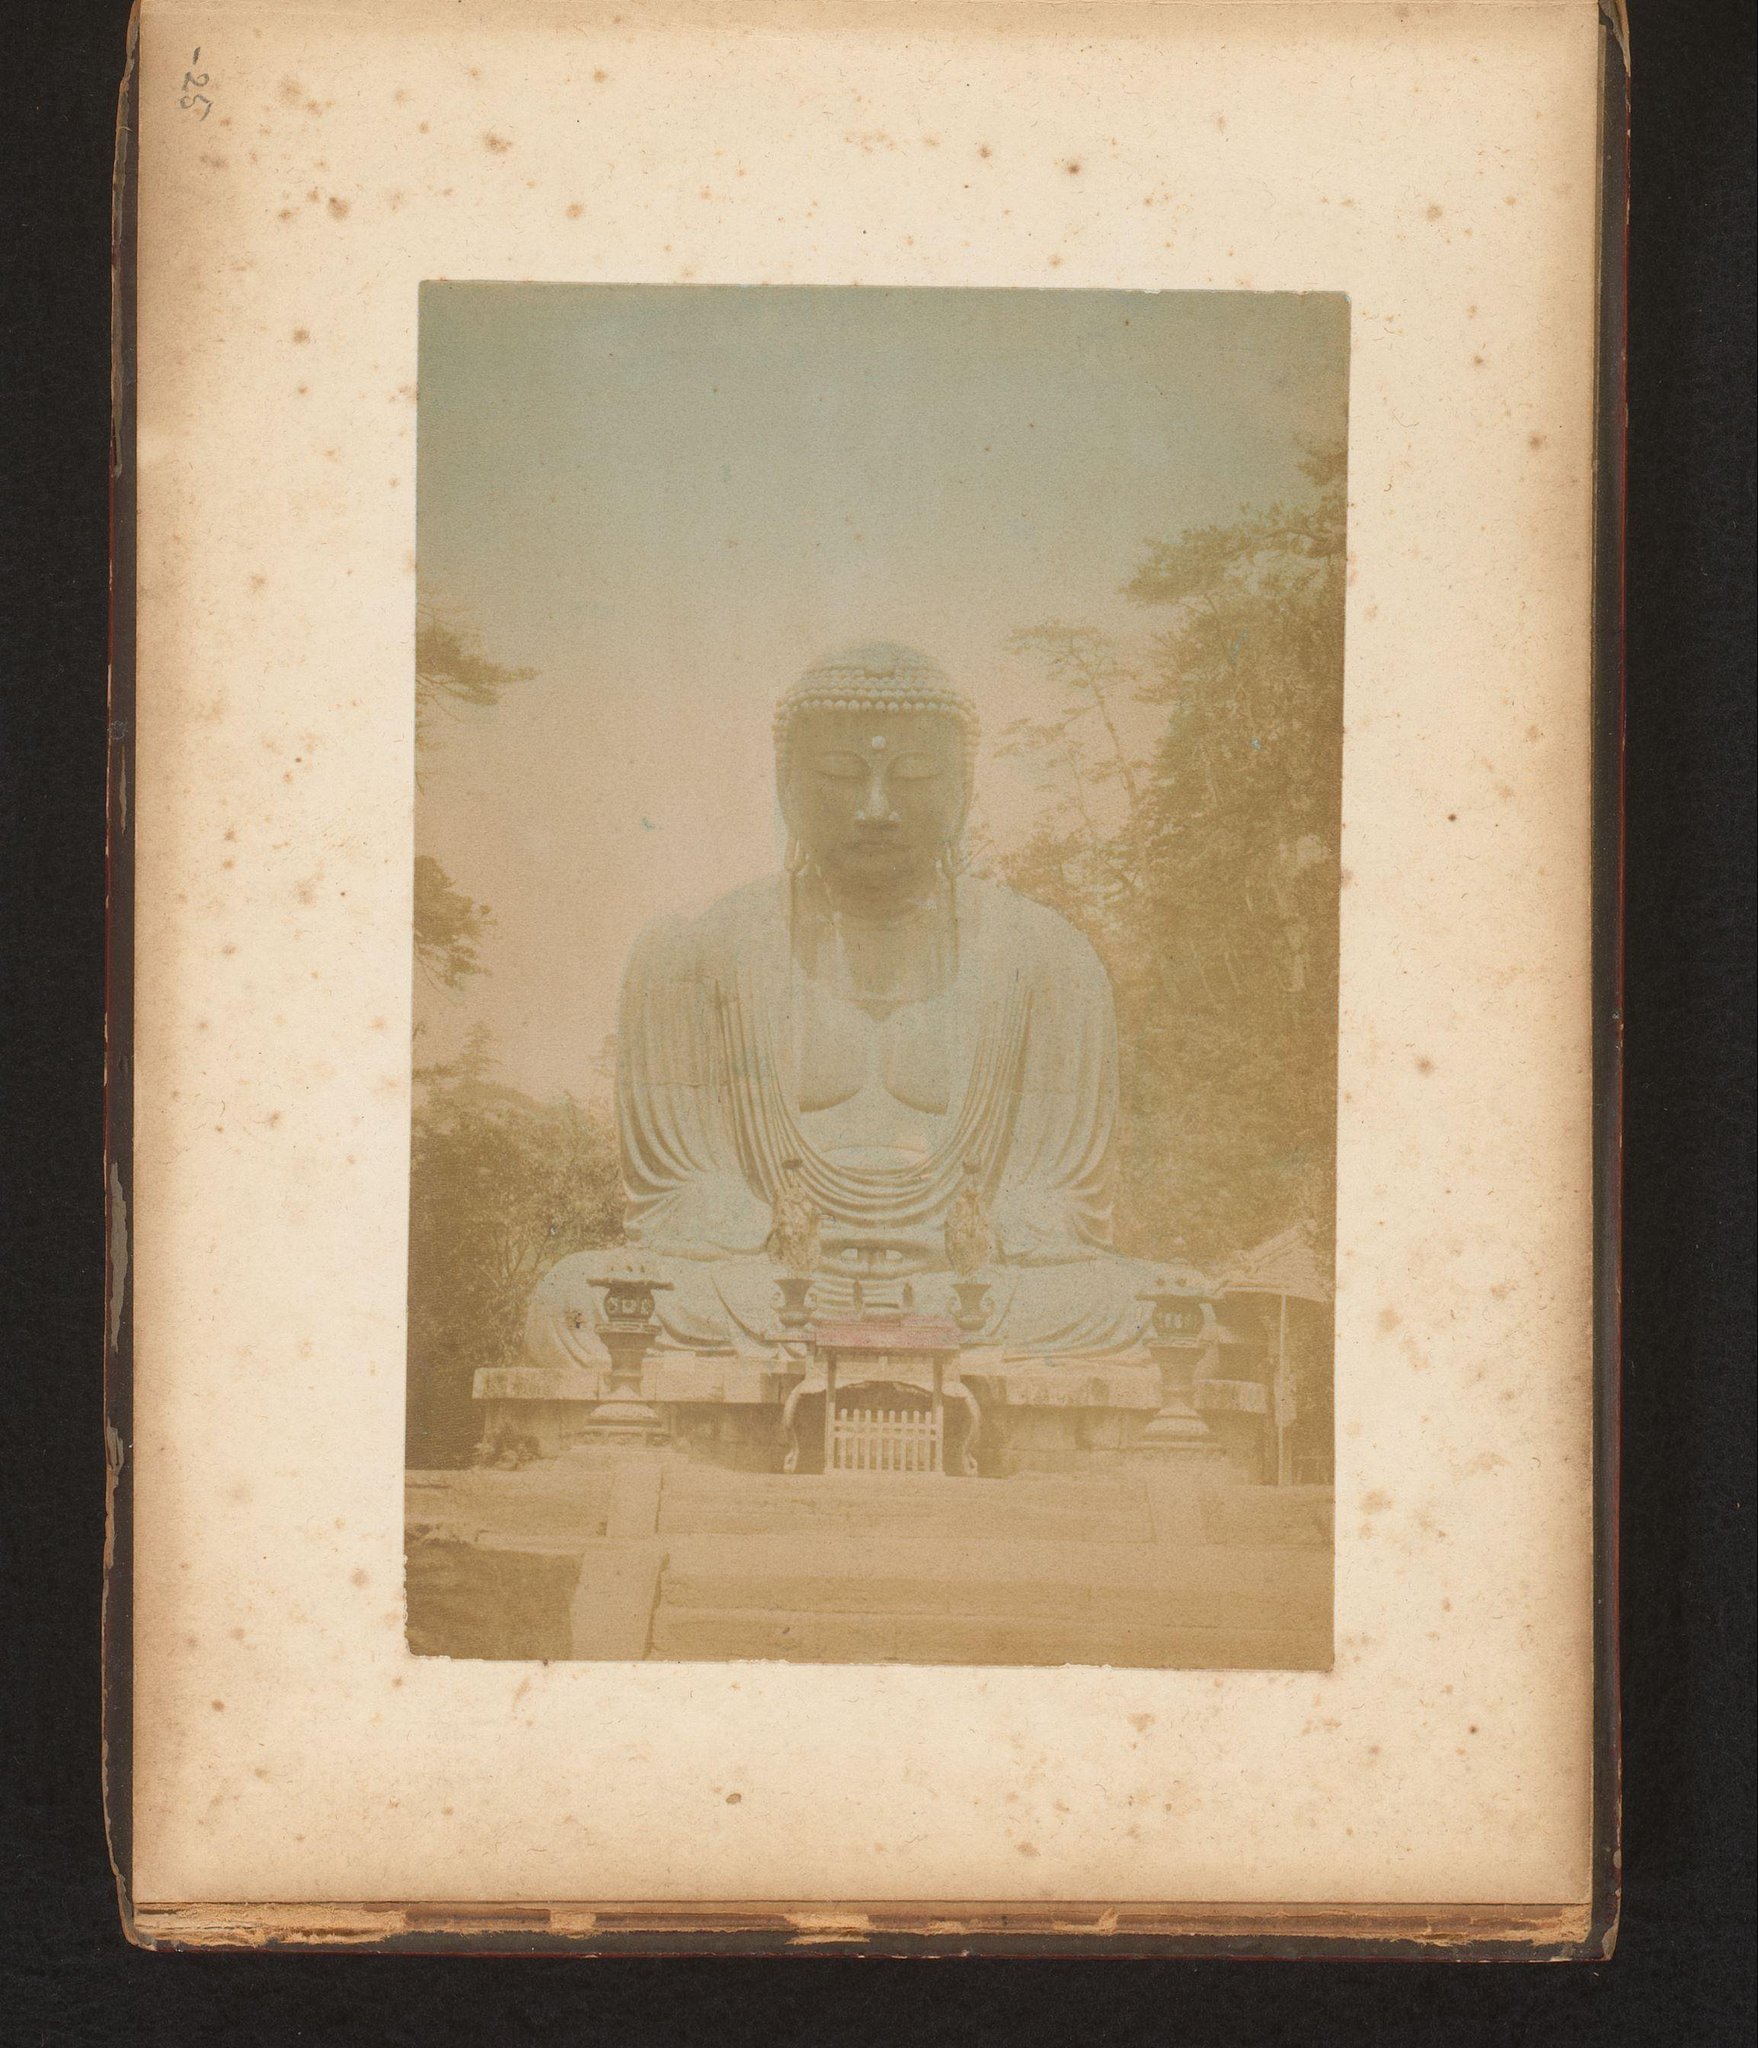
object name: album leaf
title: Gezicht op de Grote Boeddha van Kamakura bij de Kōtoku-in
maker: Anonymous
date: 1851-1900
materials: paper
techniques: albumen print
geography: kamakura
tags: temple, shrine ~ hinduism, buddhism, jainism